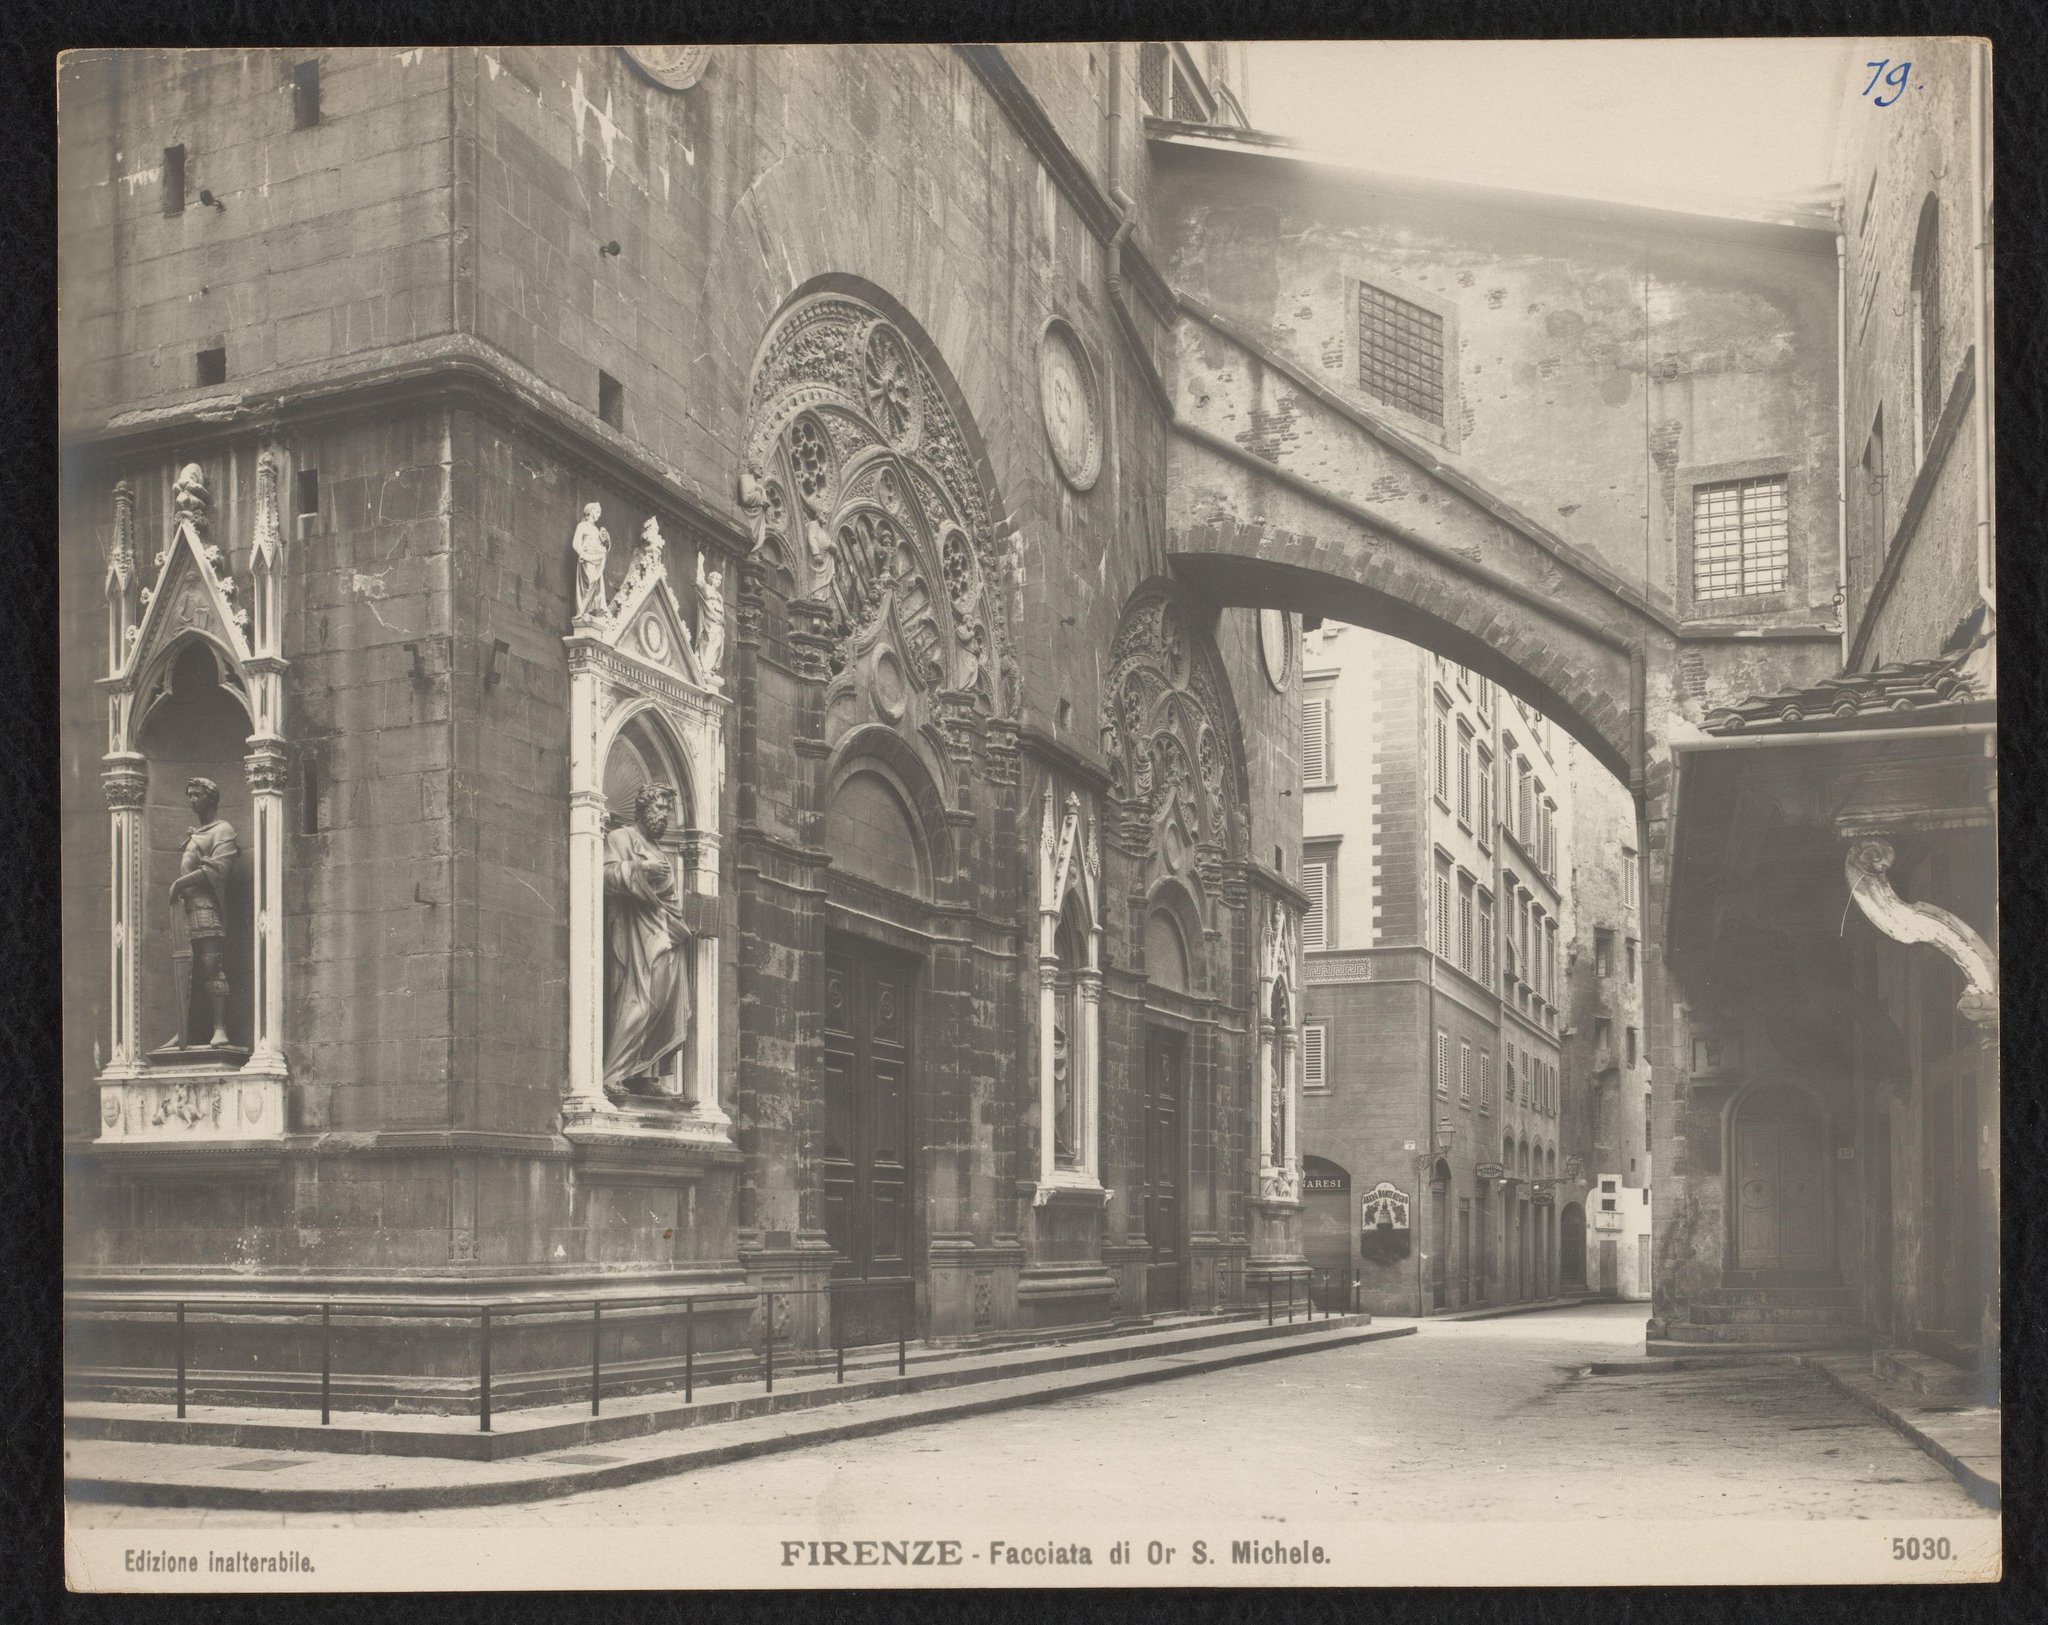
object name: photograph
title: Facciata di Or S. Michele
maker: Anonymous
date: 1900-1920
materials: paper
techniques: gelatin silver print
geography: florence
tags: parts of church exterior and annexes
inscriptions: number: ‘79.’, inscription: ‘Edizione inalterabile.’, number: ‘5030.’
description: Deze foto maakt deel uit van een omslag.